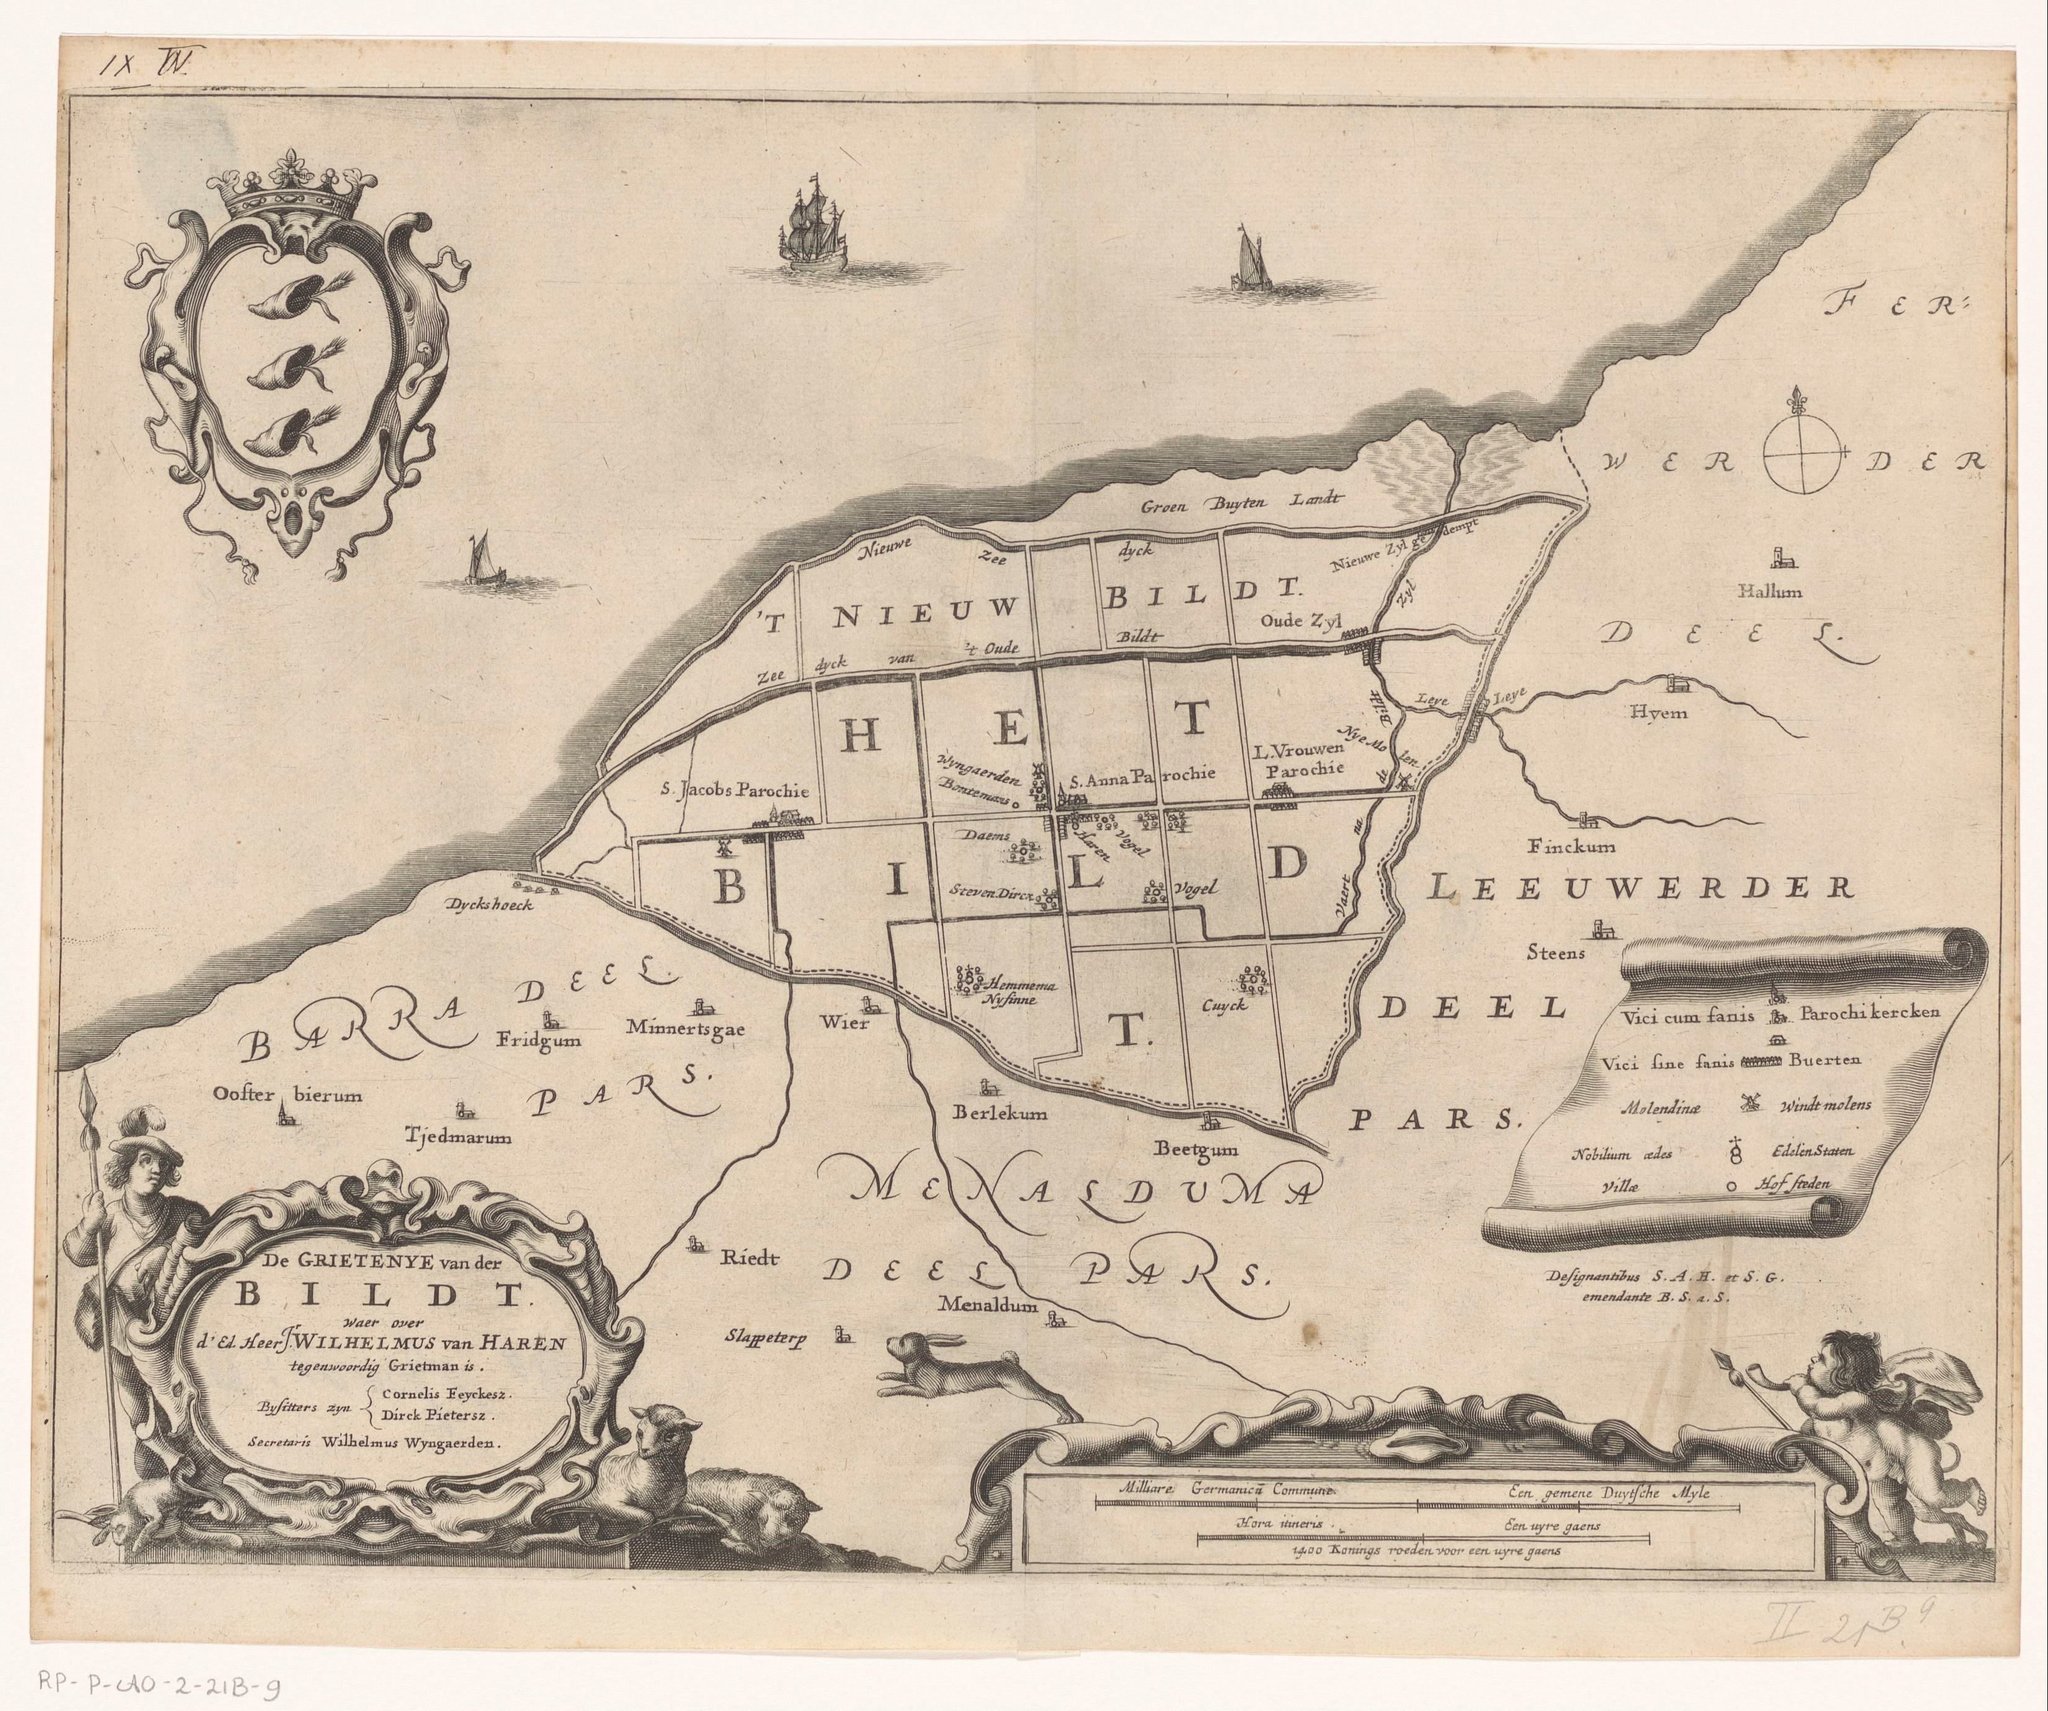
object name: print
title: Kaart van de grietenij Het Bildt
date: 1664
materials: paper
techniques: engraving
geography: friesland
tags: coat of arms (as symbol of the state, etc.), maps of separate countries or regions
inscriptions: collector's mark: Lugt 2228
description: Linksboven het wapen van Het Bildt, linksonder cartouche met titel en bestuurlijke informatie over de grietenij. Rechts legenda, rechtsonder twee schaalstokken: Milliare Germanicu commune / Een gemene Duytsche myle, Hora itineris / Een uyre gaens - van 1400 konings roeden voor een uyre gaens.